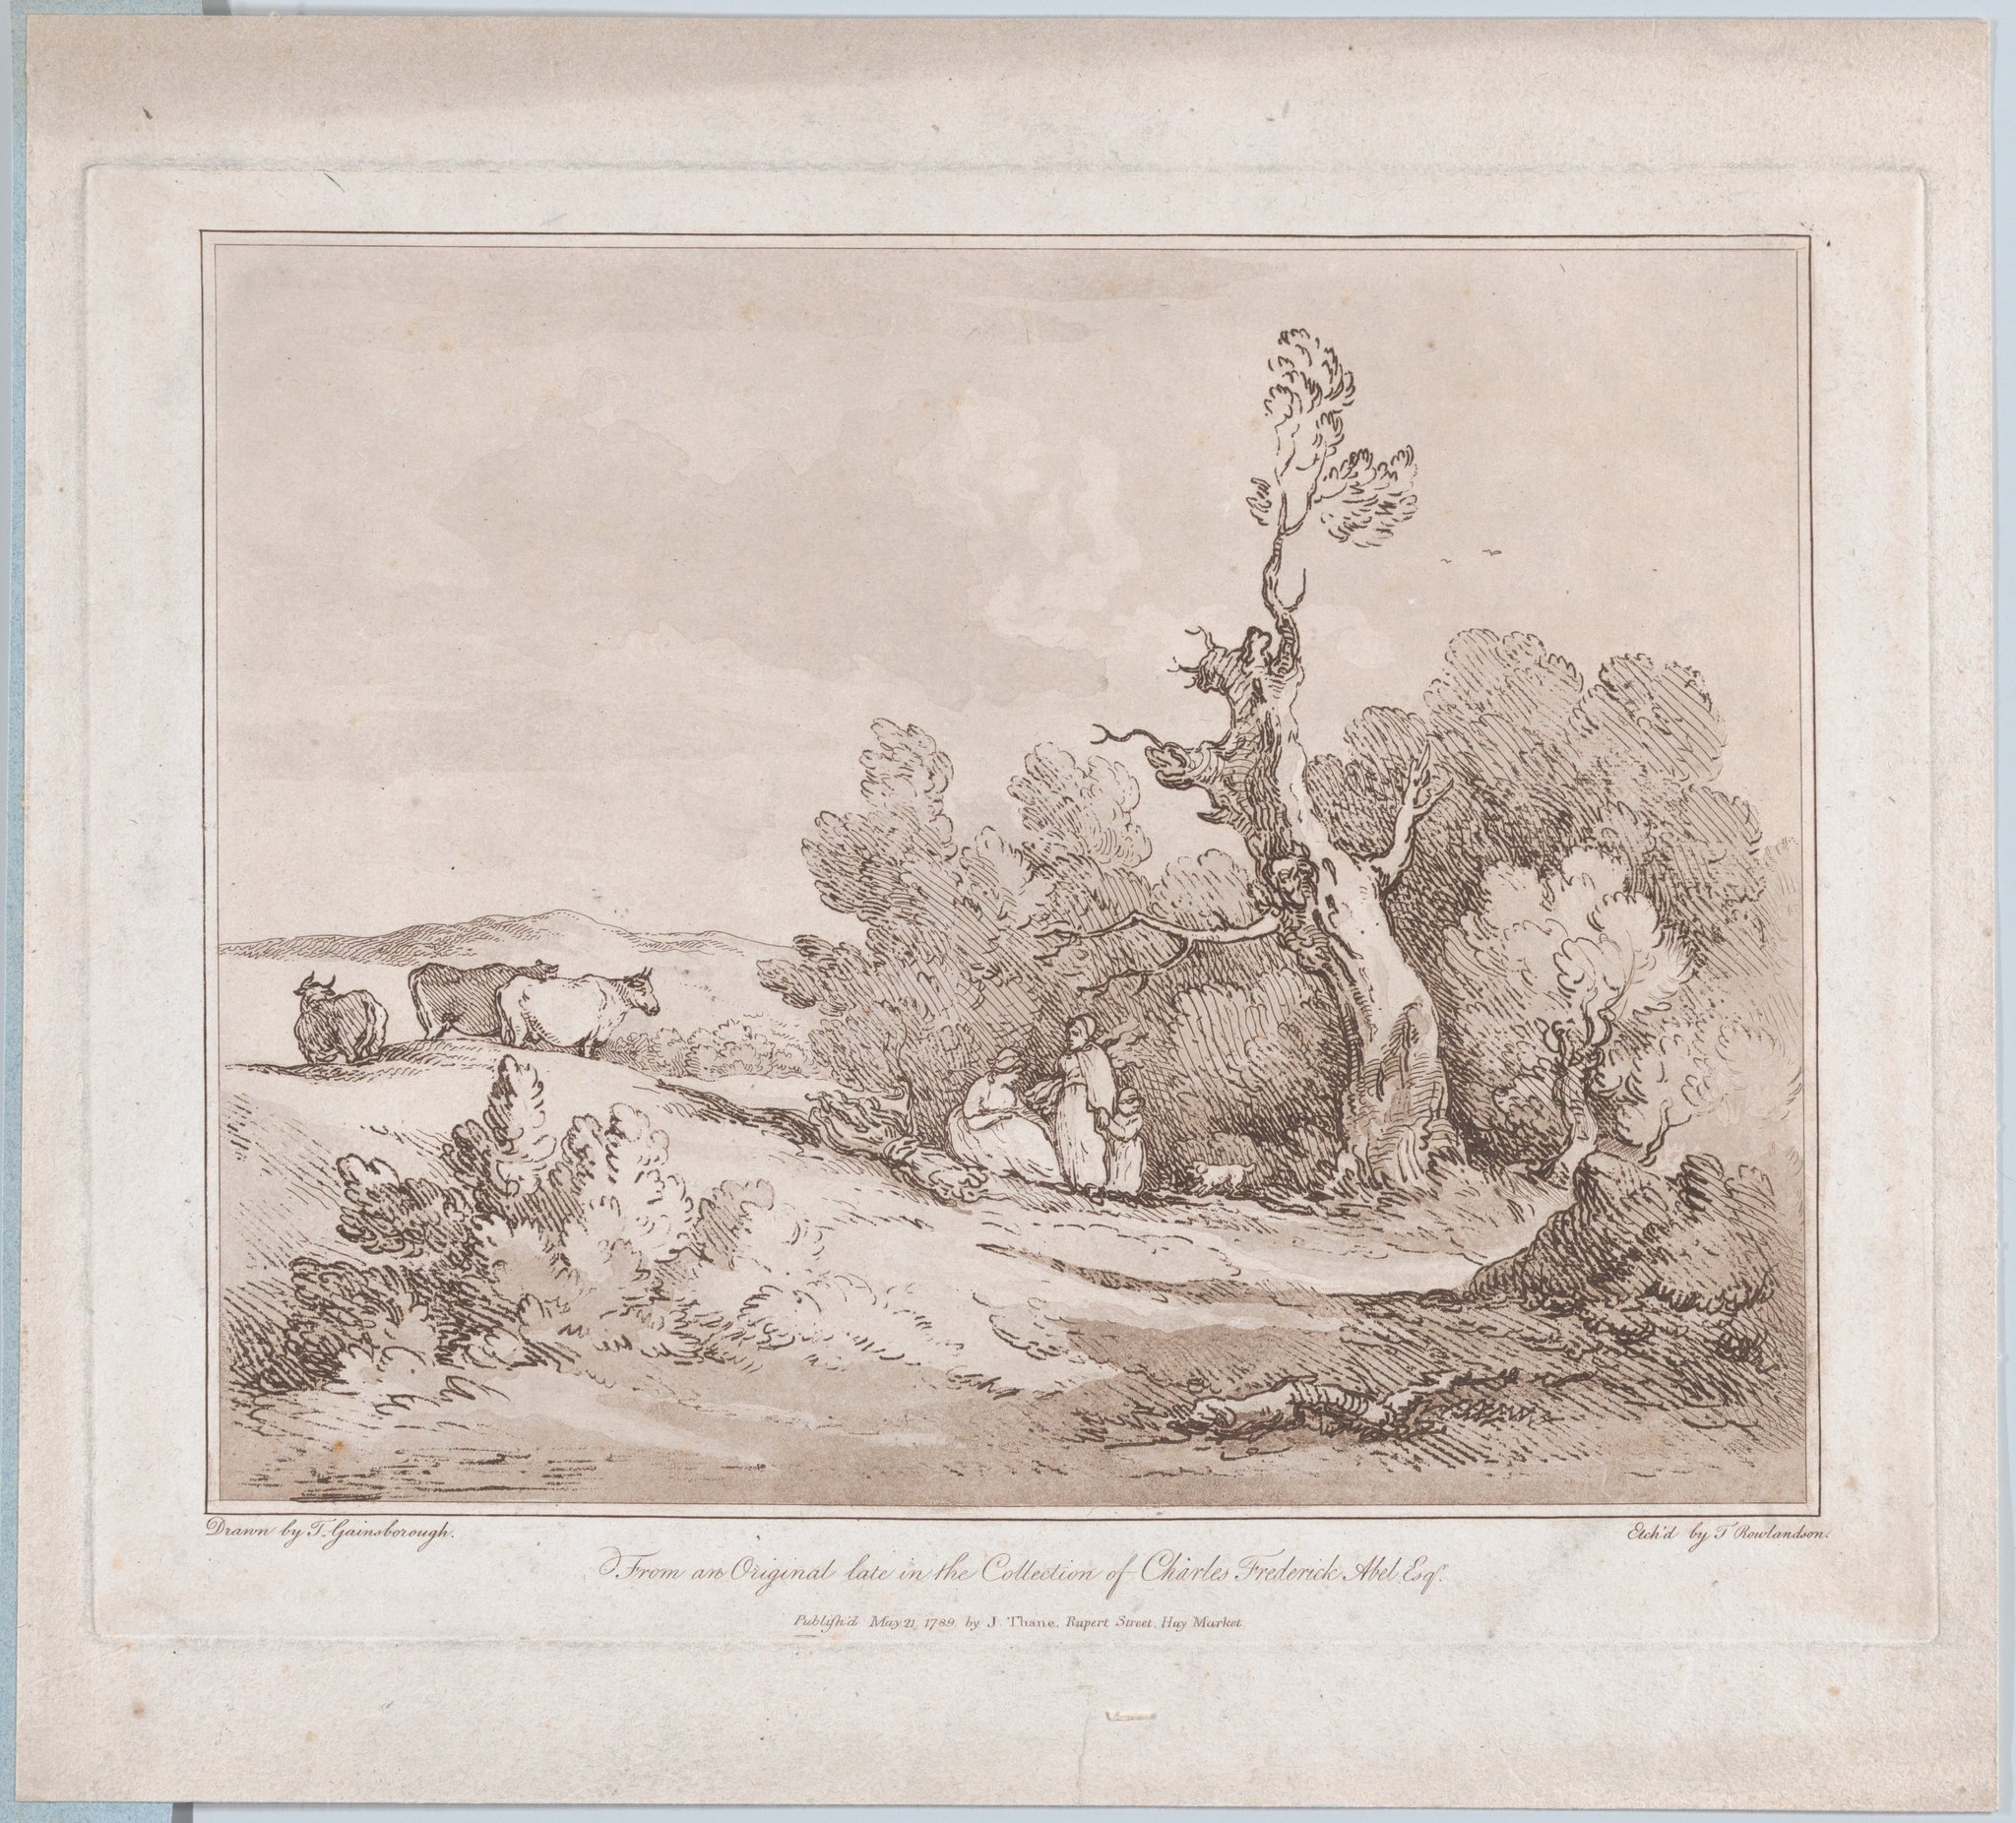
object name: print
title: Landscape with Figures Collecting Wood Beneath Gnarled Trees, or, Cattle, River side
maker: thomas rowlandson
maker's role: artist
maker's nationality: british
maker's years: 1757-1827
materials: ink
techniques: aquatint, etching, printing